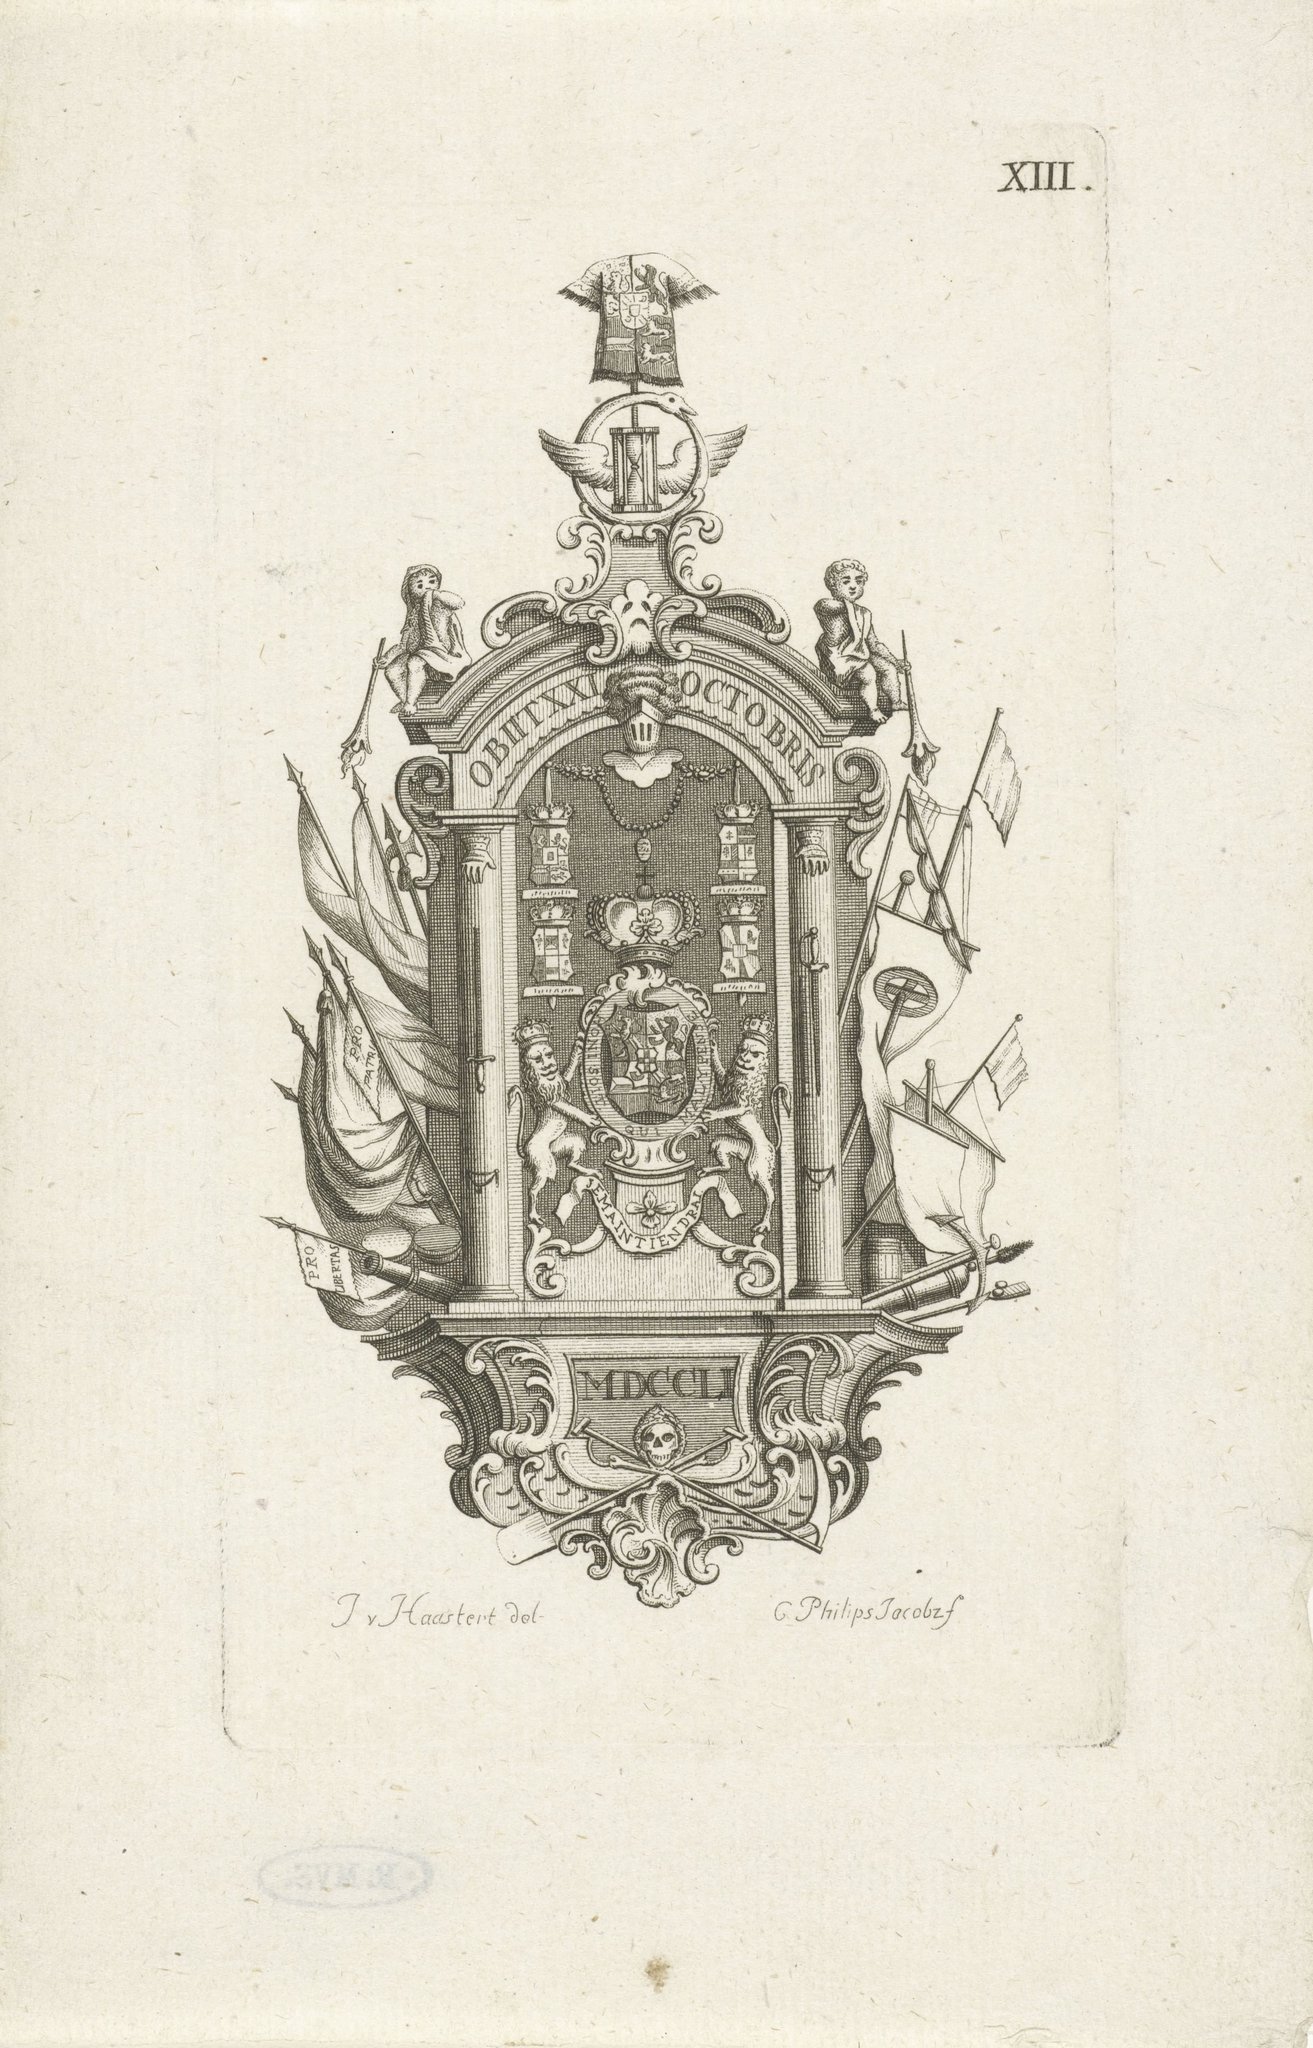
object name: print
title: Epitaaf voor de overleden prins Willem IV, 1751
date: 1752-1789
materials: paper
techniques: etching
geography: amsterdam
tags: the hague, willem iv (prins van oranje-nassau), 'vanitas' symbols, epitaph, delft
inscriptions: collector's mark: Lugt 2228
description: Monument of gedenksteen voor de in 1751 overleden prins Willem IV. Monument opgebouwd uit zuilen en wapentrofeeën, bekroond door een gevleugelde zandloper en de Nassause wapenrok. Centraal het wapen van de prins vastgehouden door twee leeuwen. Rechtsboven gemerkt: XIII.